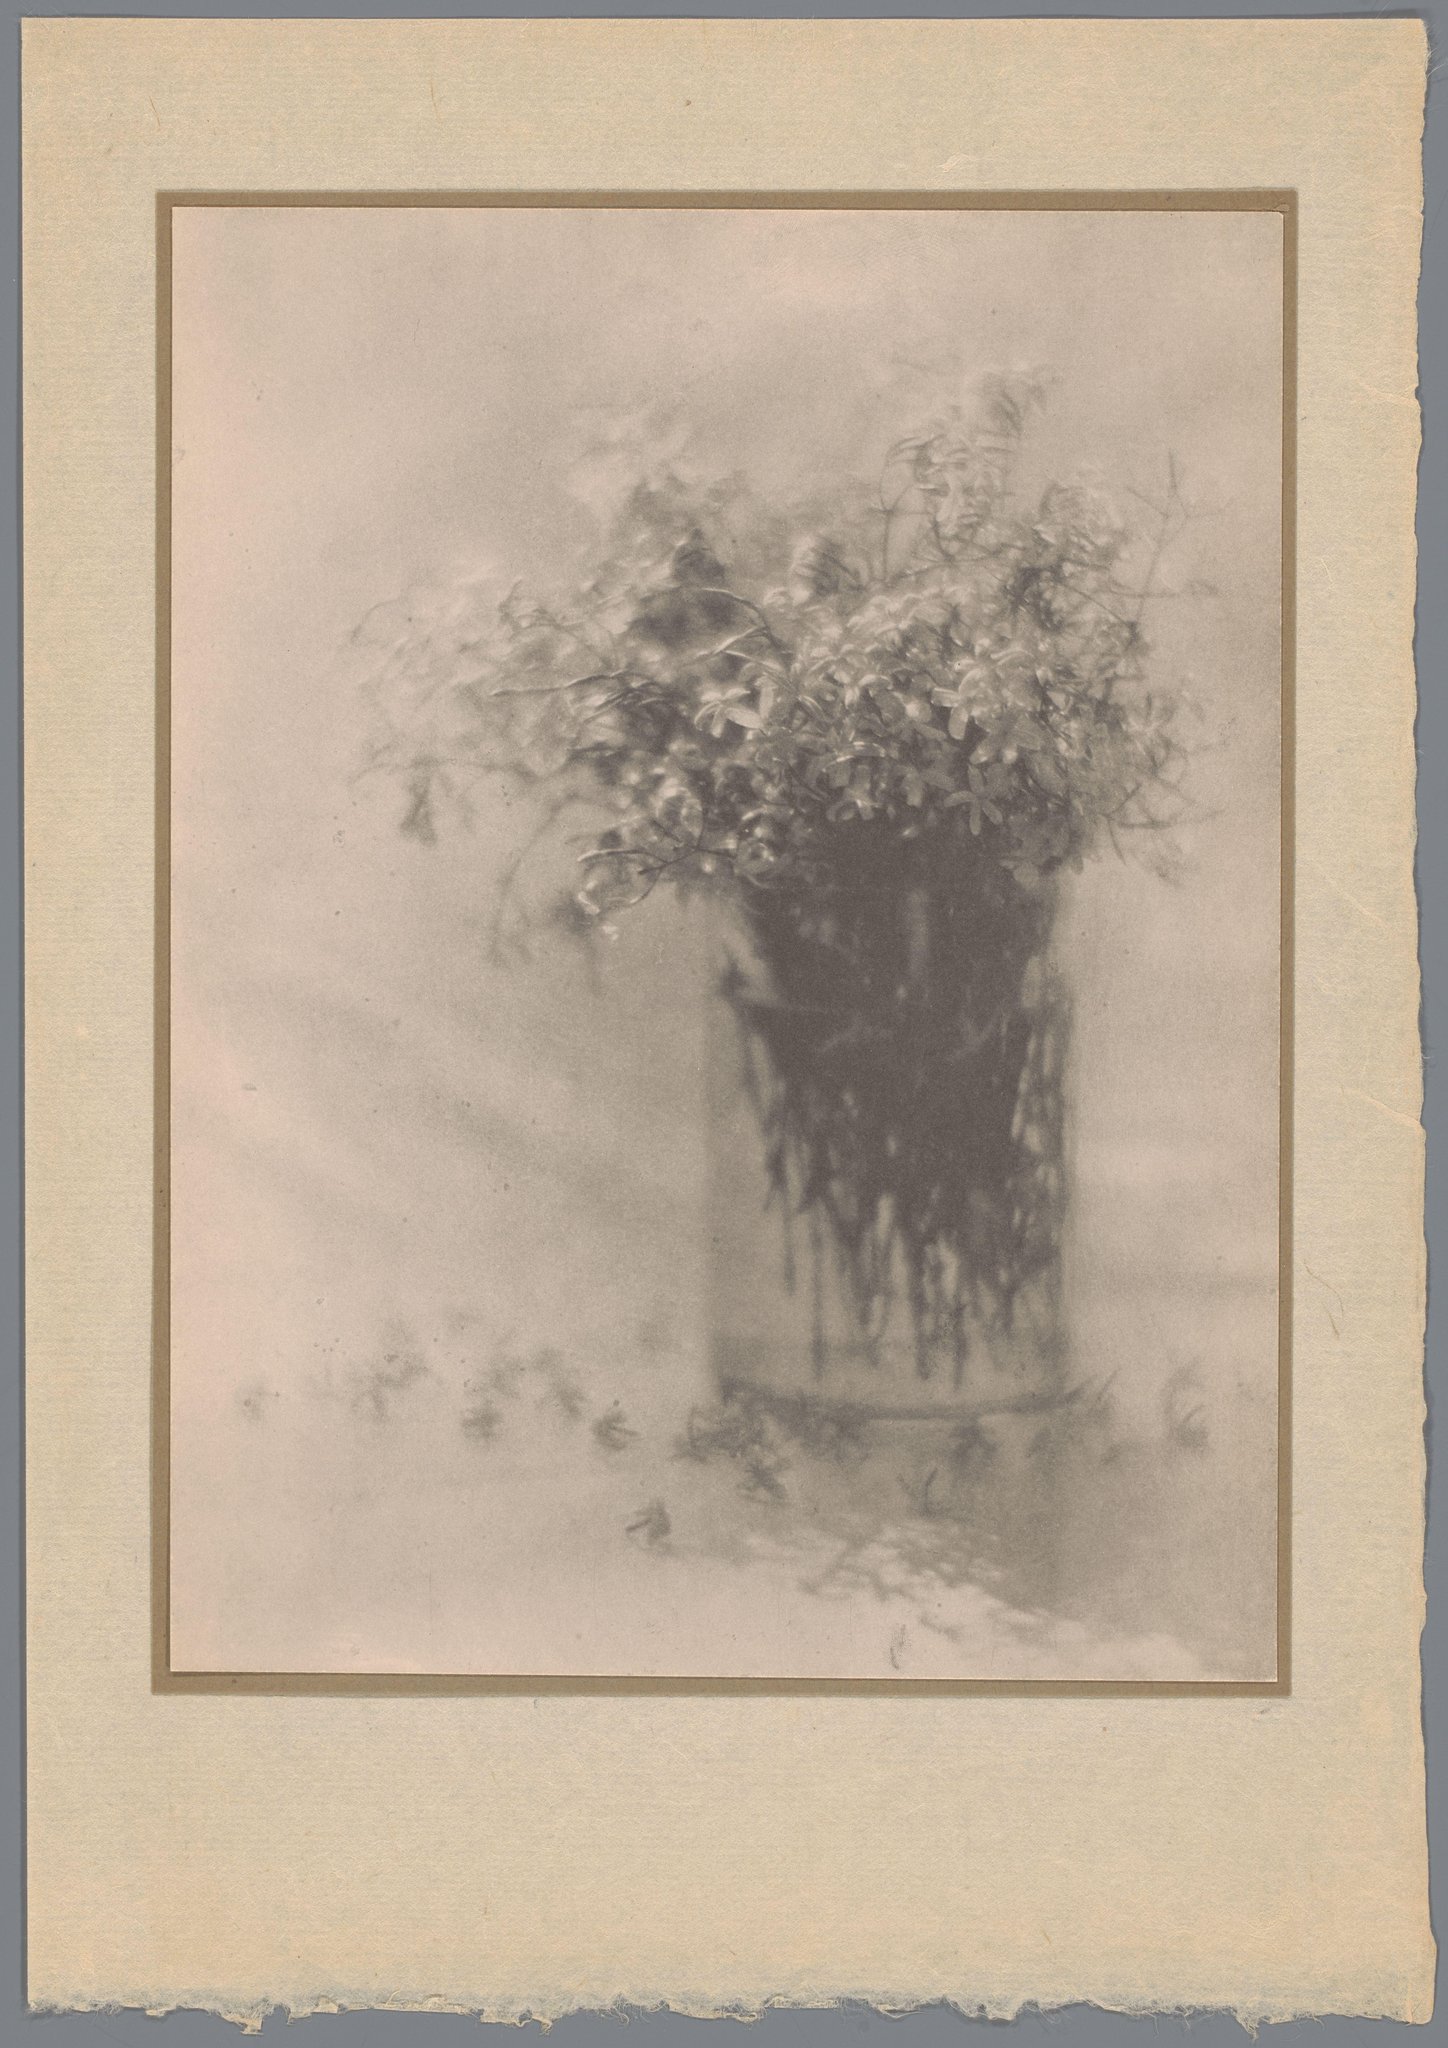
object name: photomechanical print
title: Stilleven, vaas met bloemen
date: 1908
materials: cardboard, paper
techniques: photoaquatint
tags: flowers in a vase